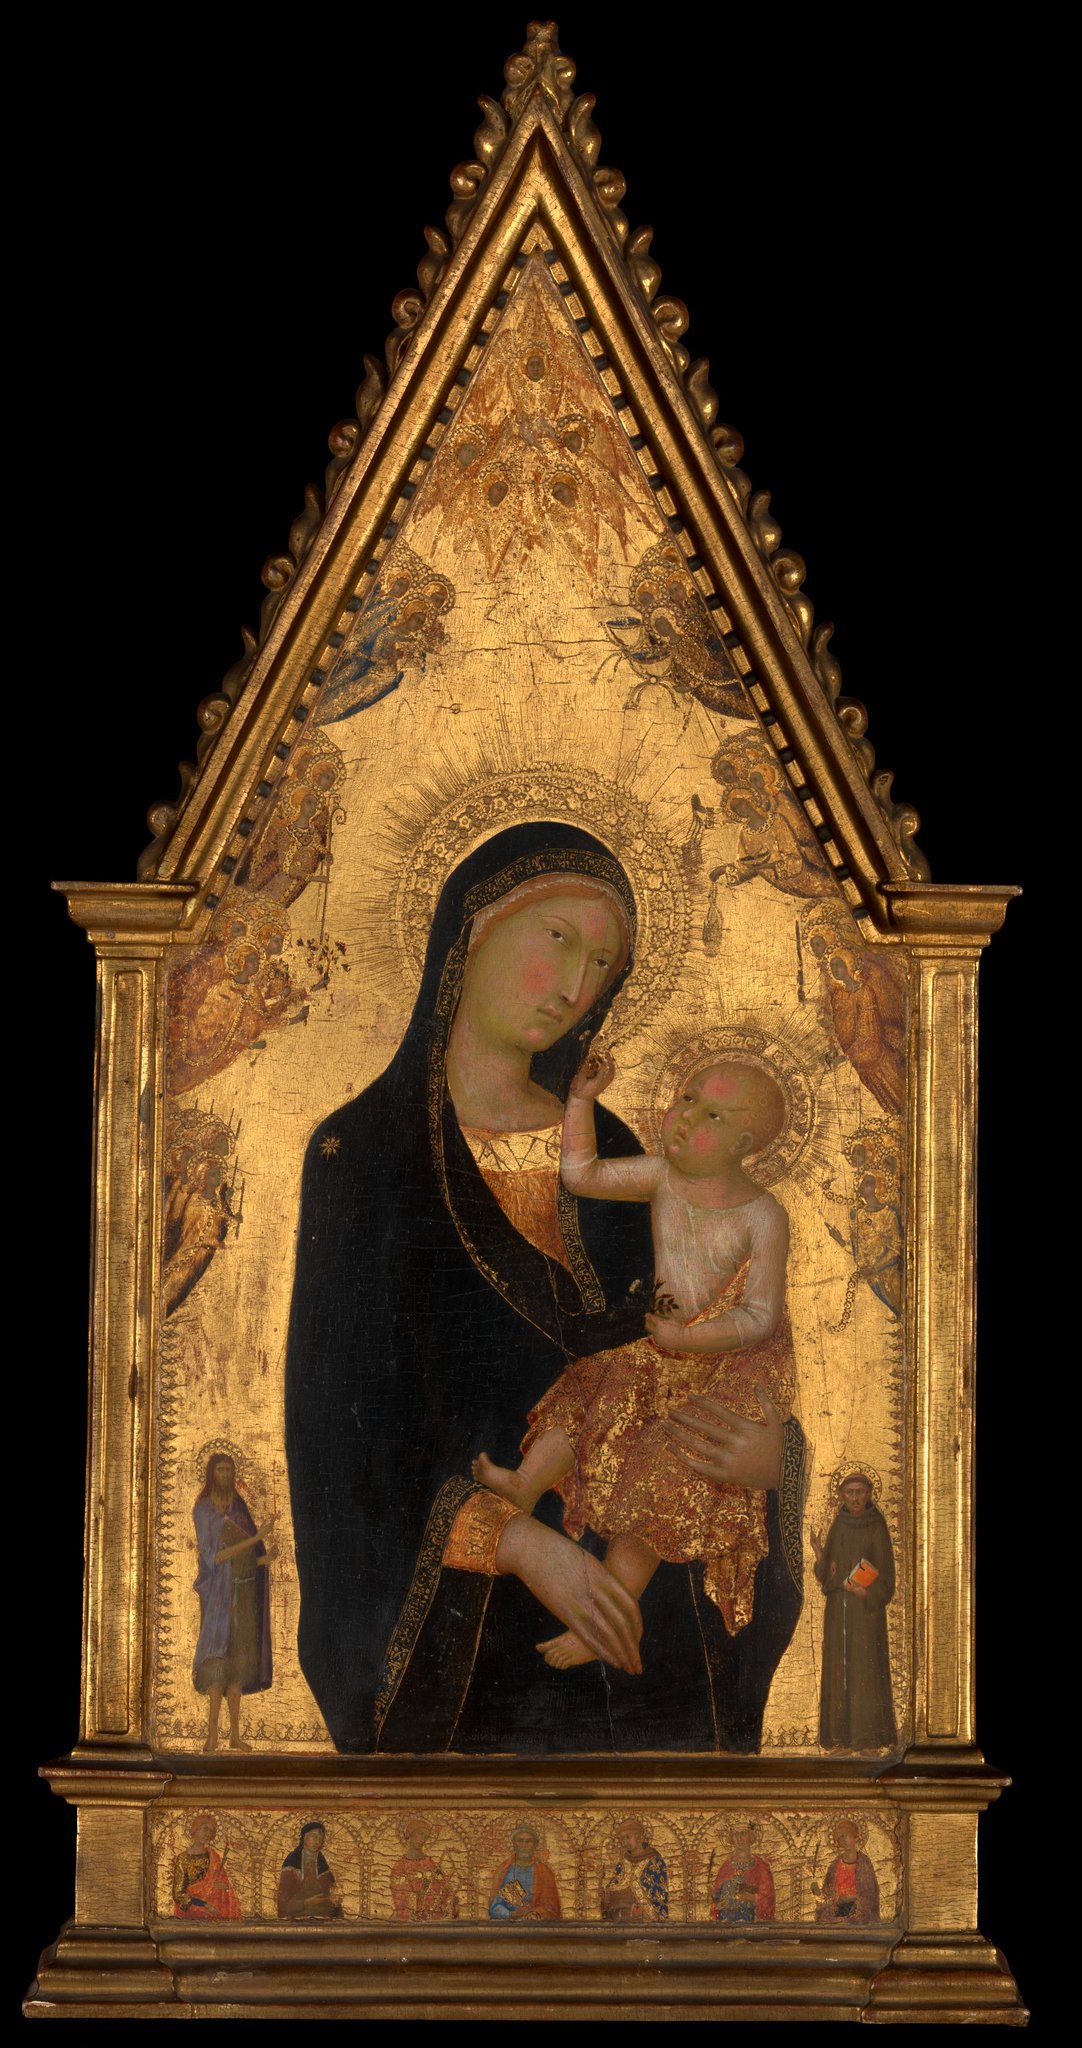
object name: painting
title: Madonna and Child with Saints and Angels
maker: lippo memmi (filippo di memmo)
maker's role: artist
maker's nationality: italian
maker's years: 1317-1356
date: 1350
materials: gold leaf, paint, wood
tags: angels,madonna and child,saint francis,saint john the baptist